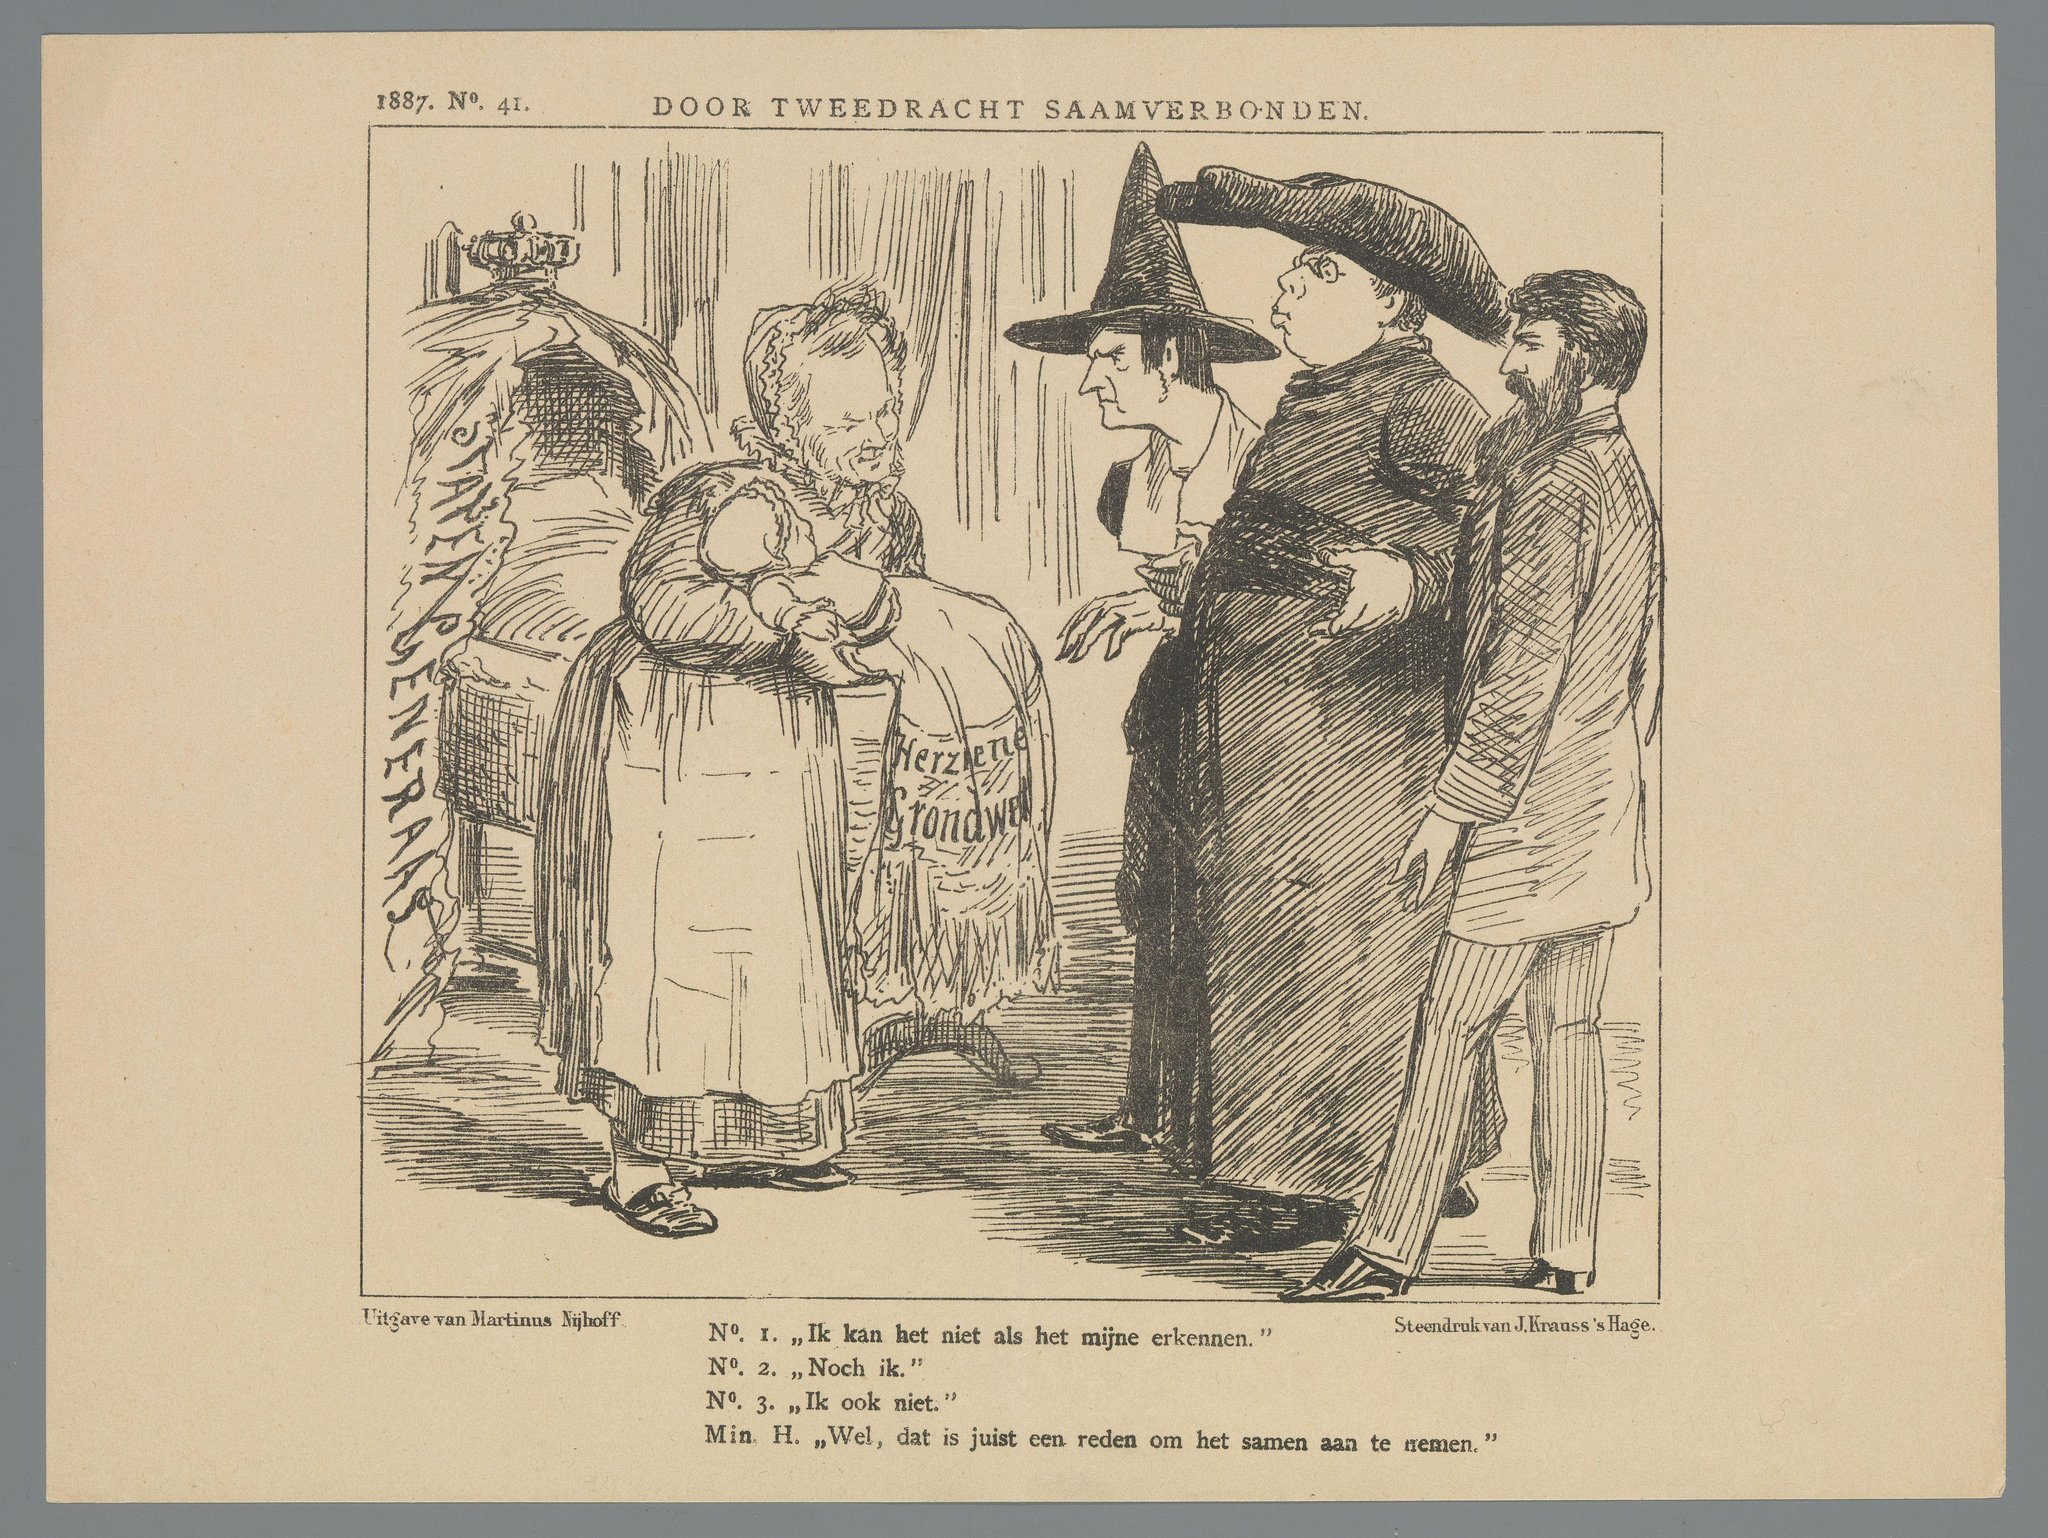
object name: print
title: Door tweedracht saamverbonden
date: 1887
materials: paper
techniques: lithograph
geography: netherlands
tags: amsterdam, politician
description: Spotprent over de grondwetsherziening. Minister Heemskerk met het pasgeboren kind. Plaat verschenen bij het weekblad De Nederlandsche Spectator, nr. 41, 1887.